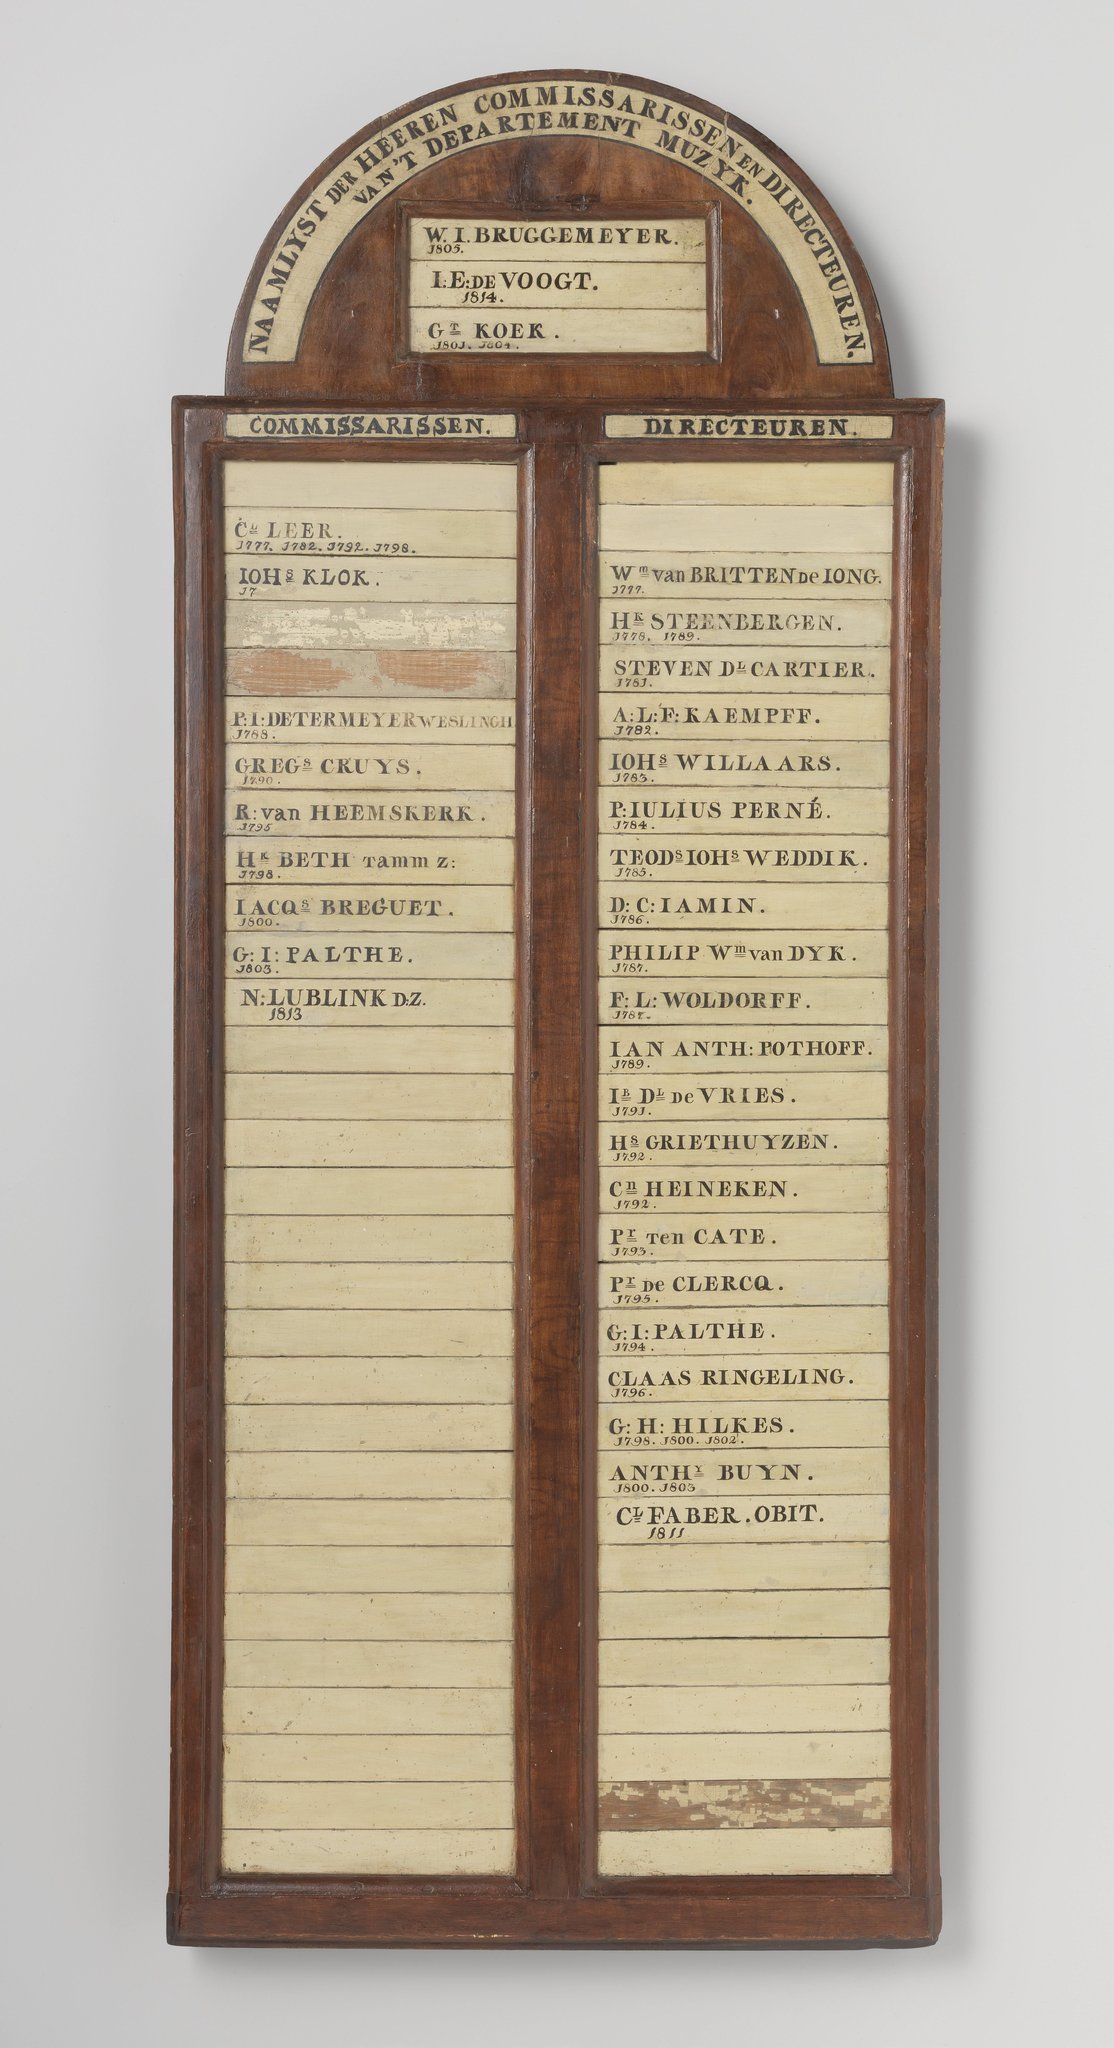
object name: naamlijst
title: Houten naamlijst Felix Meritis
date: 1750-1850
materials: iron, wood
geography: netherlands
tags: felix meritis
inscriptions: : ‘NAAMLIJST DER HEEREN COMMISSARISSEN EN DIRECTEUREN. VAN 'T DEPARTEMENT MUZYK’